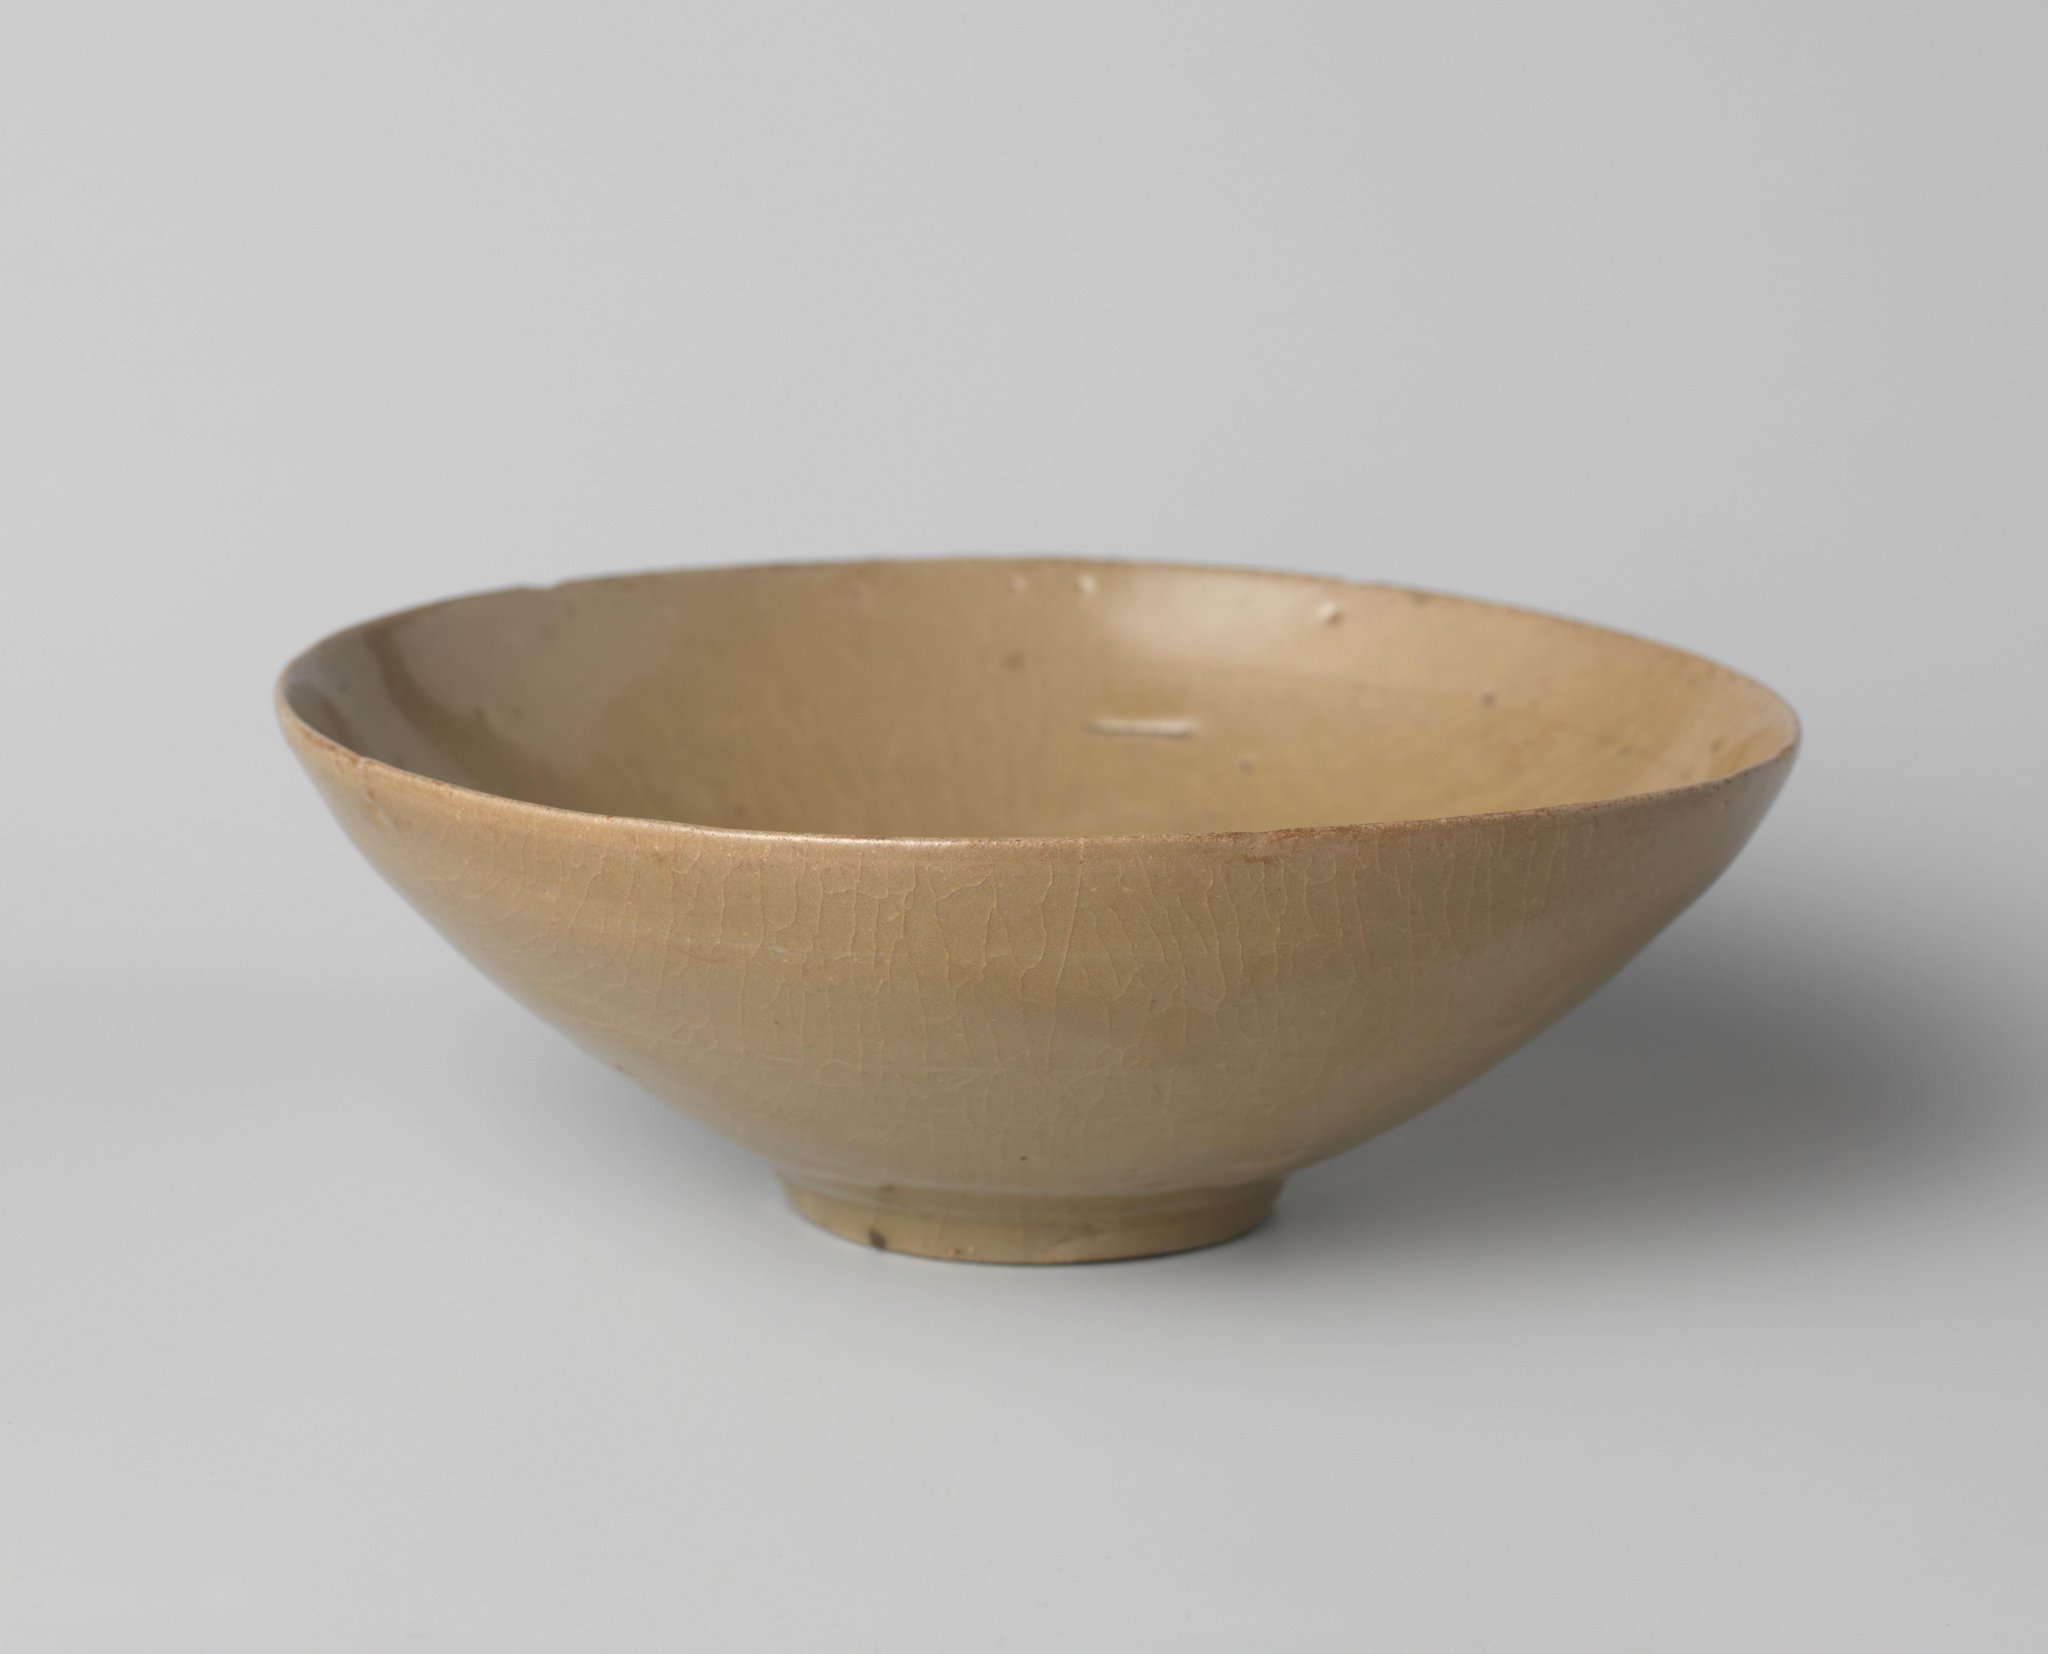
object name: bowl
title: Bowl with a green glaze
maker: Anonymous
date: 1200-1399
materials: glaze, stoneware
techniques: firing, turning, vitrification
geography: korea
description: Kom van steengoed, bedekt met een gecraqueleerd groen glazuur. Op de binnenwand driemaal een, slecht zichtbare, ingegrifte bloem. Vier proenen binnen de voetring. Celadon.